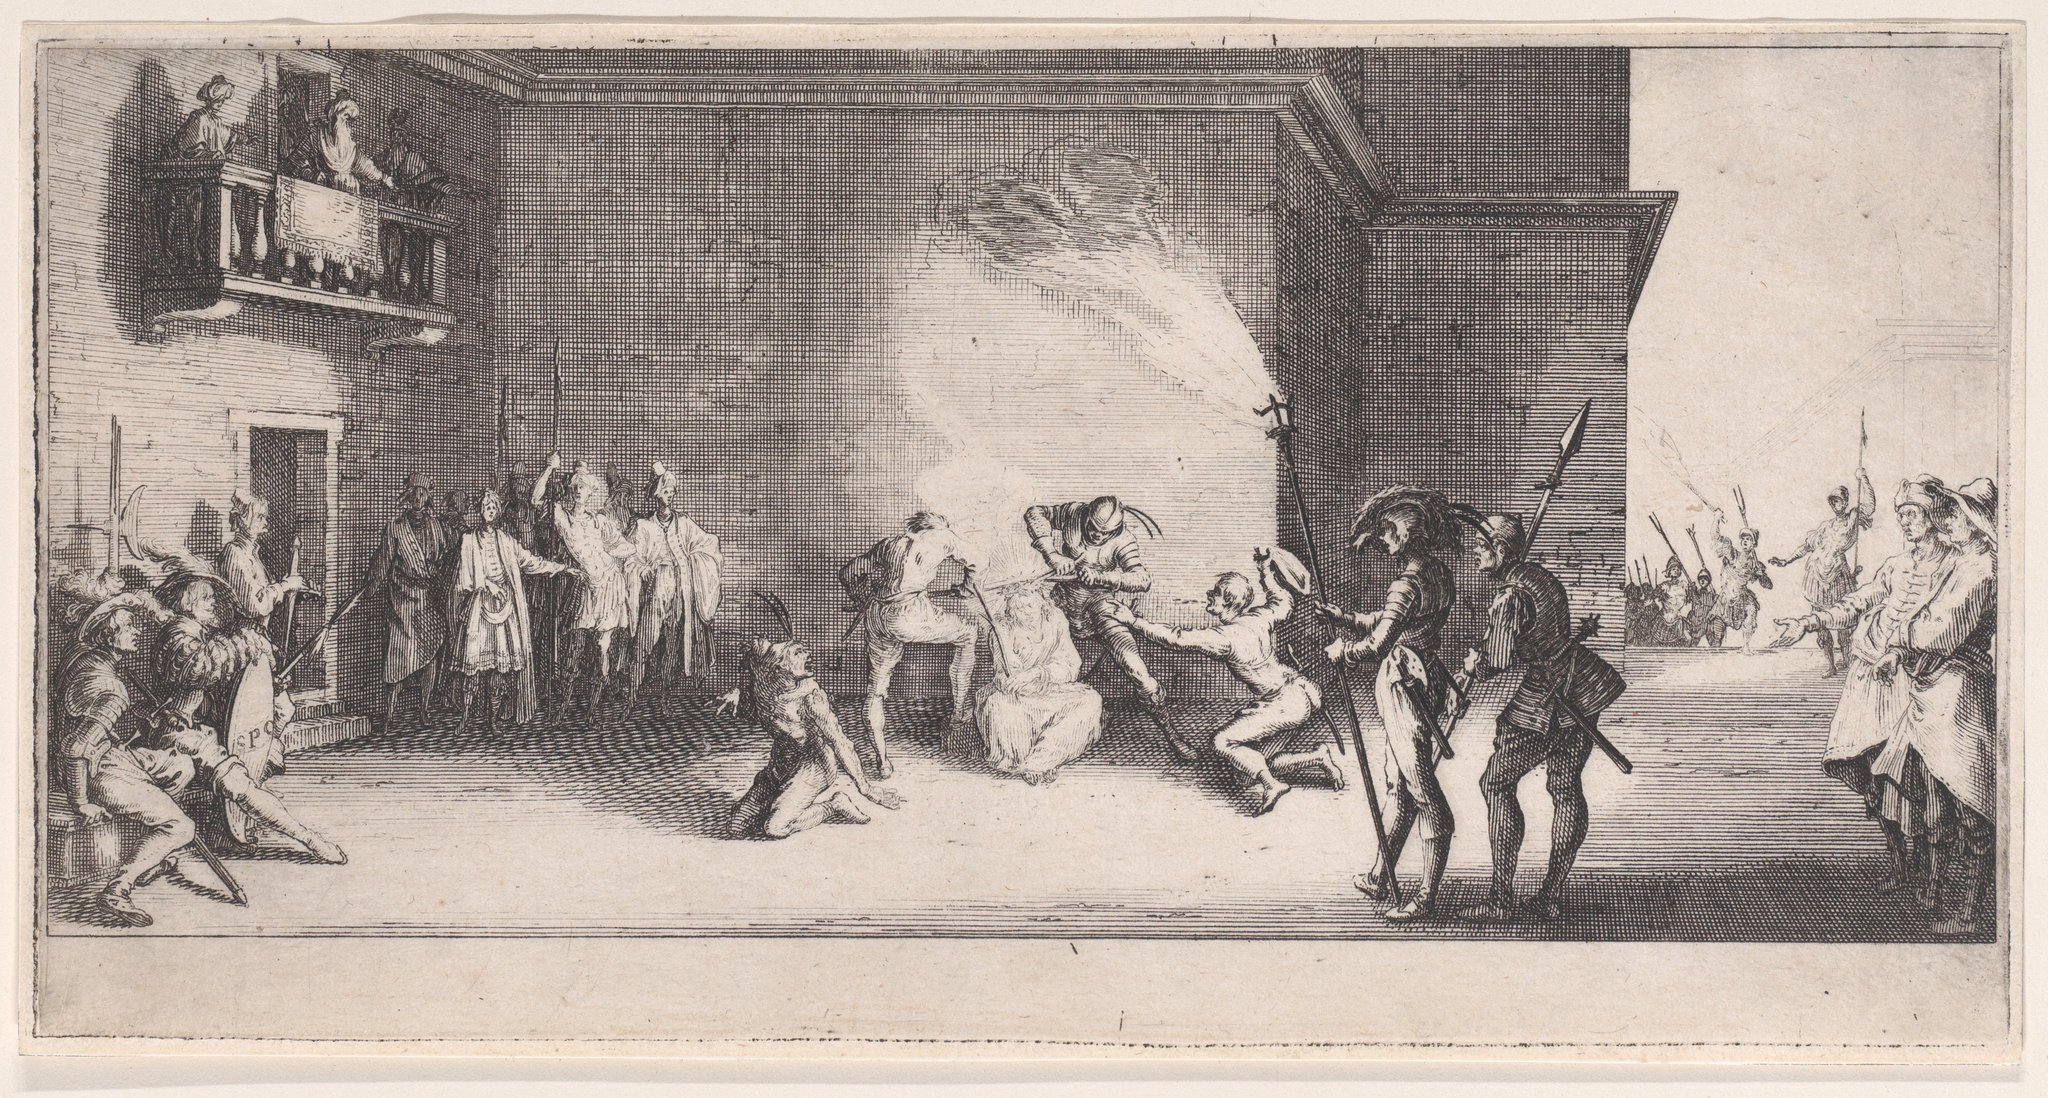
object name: print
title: Le Couronnement D'Épines (The Crowning with Thorns), from La Grande Passion (The Large Passion)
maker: jacques callot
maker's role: artist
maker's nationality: french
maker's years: 1592-1635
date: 1619-1624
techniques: engraving, etching